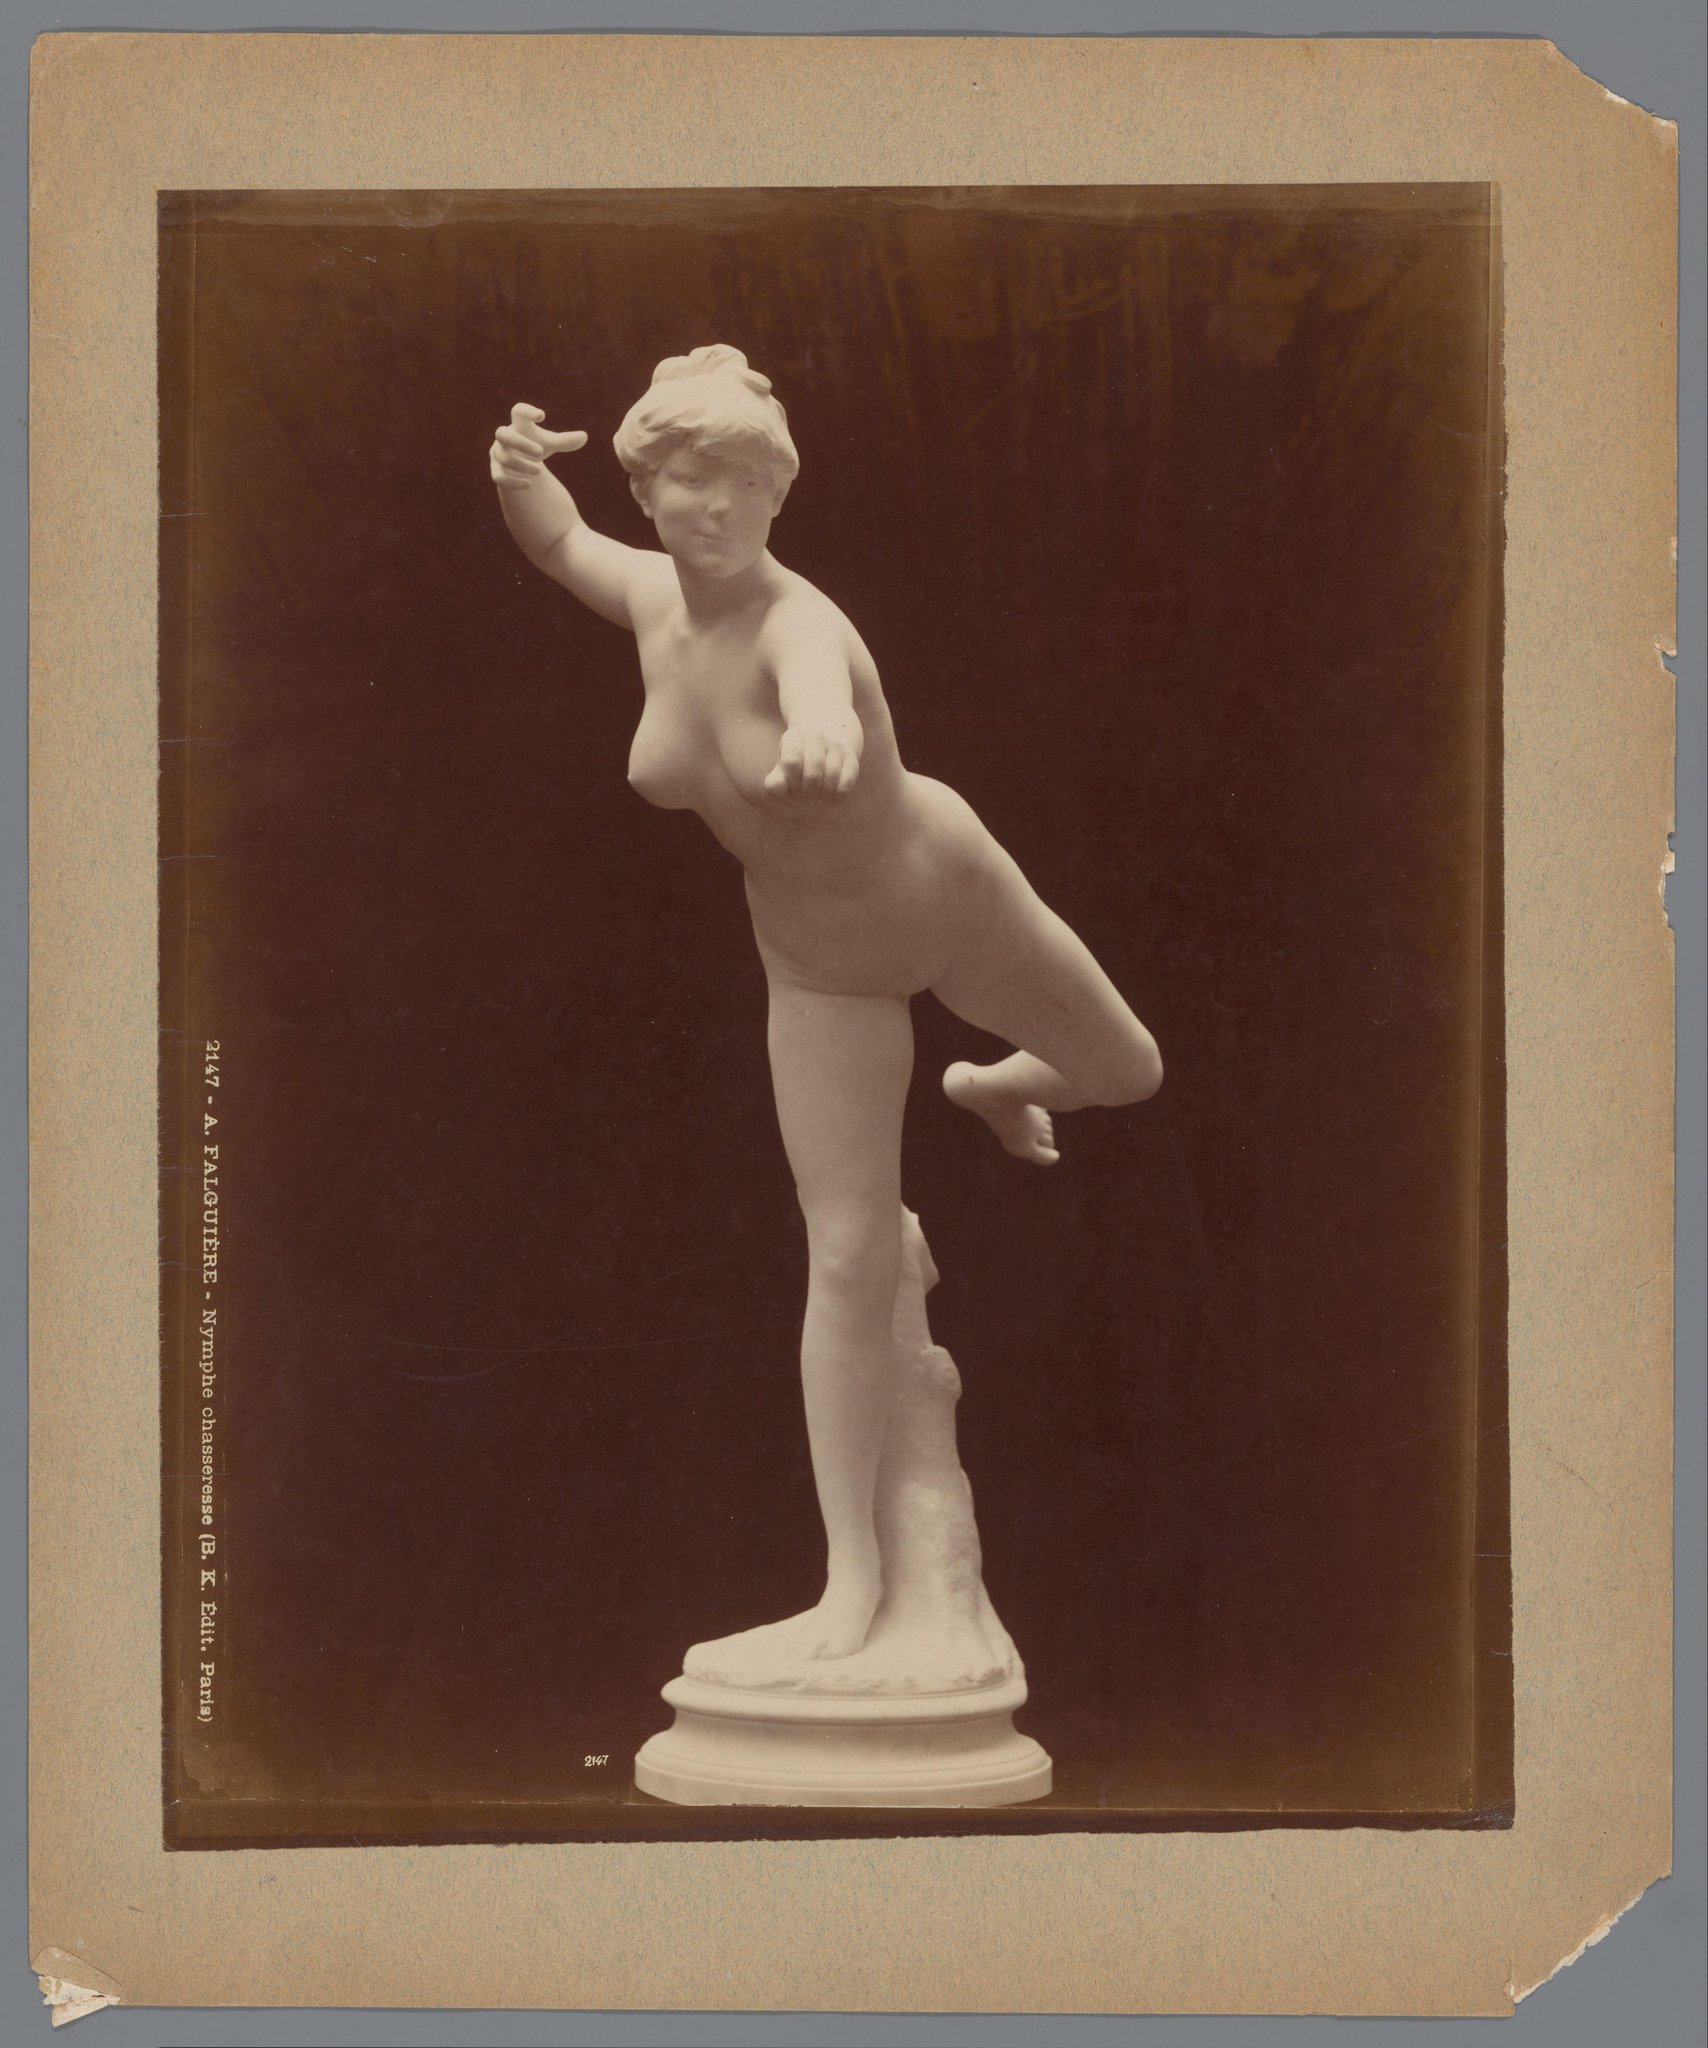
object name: photograph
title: A. FALGUIÈRE - Nymphe chasseresse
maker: Anonymous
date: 1875-1900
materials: cardboard, photographic support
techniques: albumen print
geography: paris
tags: hunting, chase, woman (showing herself) undressed, quasi-nude, nymphs (in general); 'ninfe in commune' (ripa), sculpture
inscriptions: inscription: ‘XI pl 9’, collector's mark: Lugt 3937, number: ‘2147’